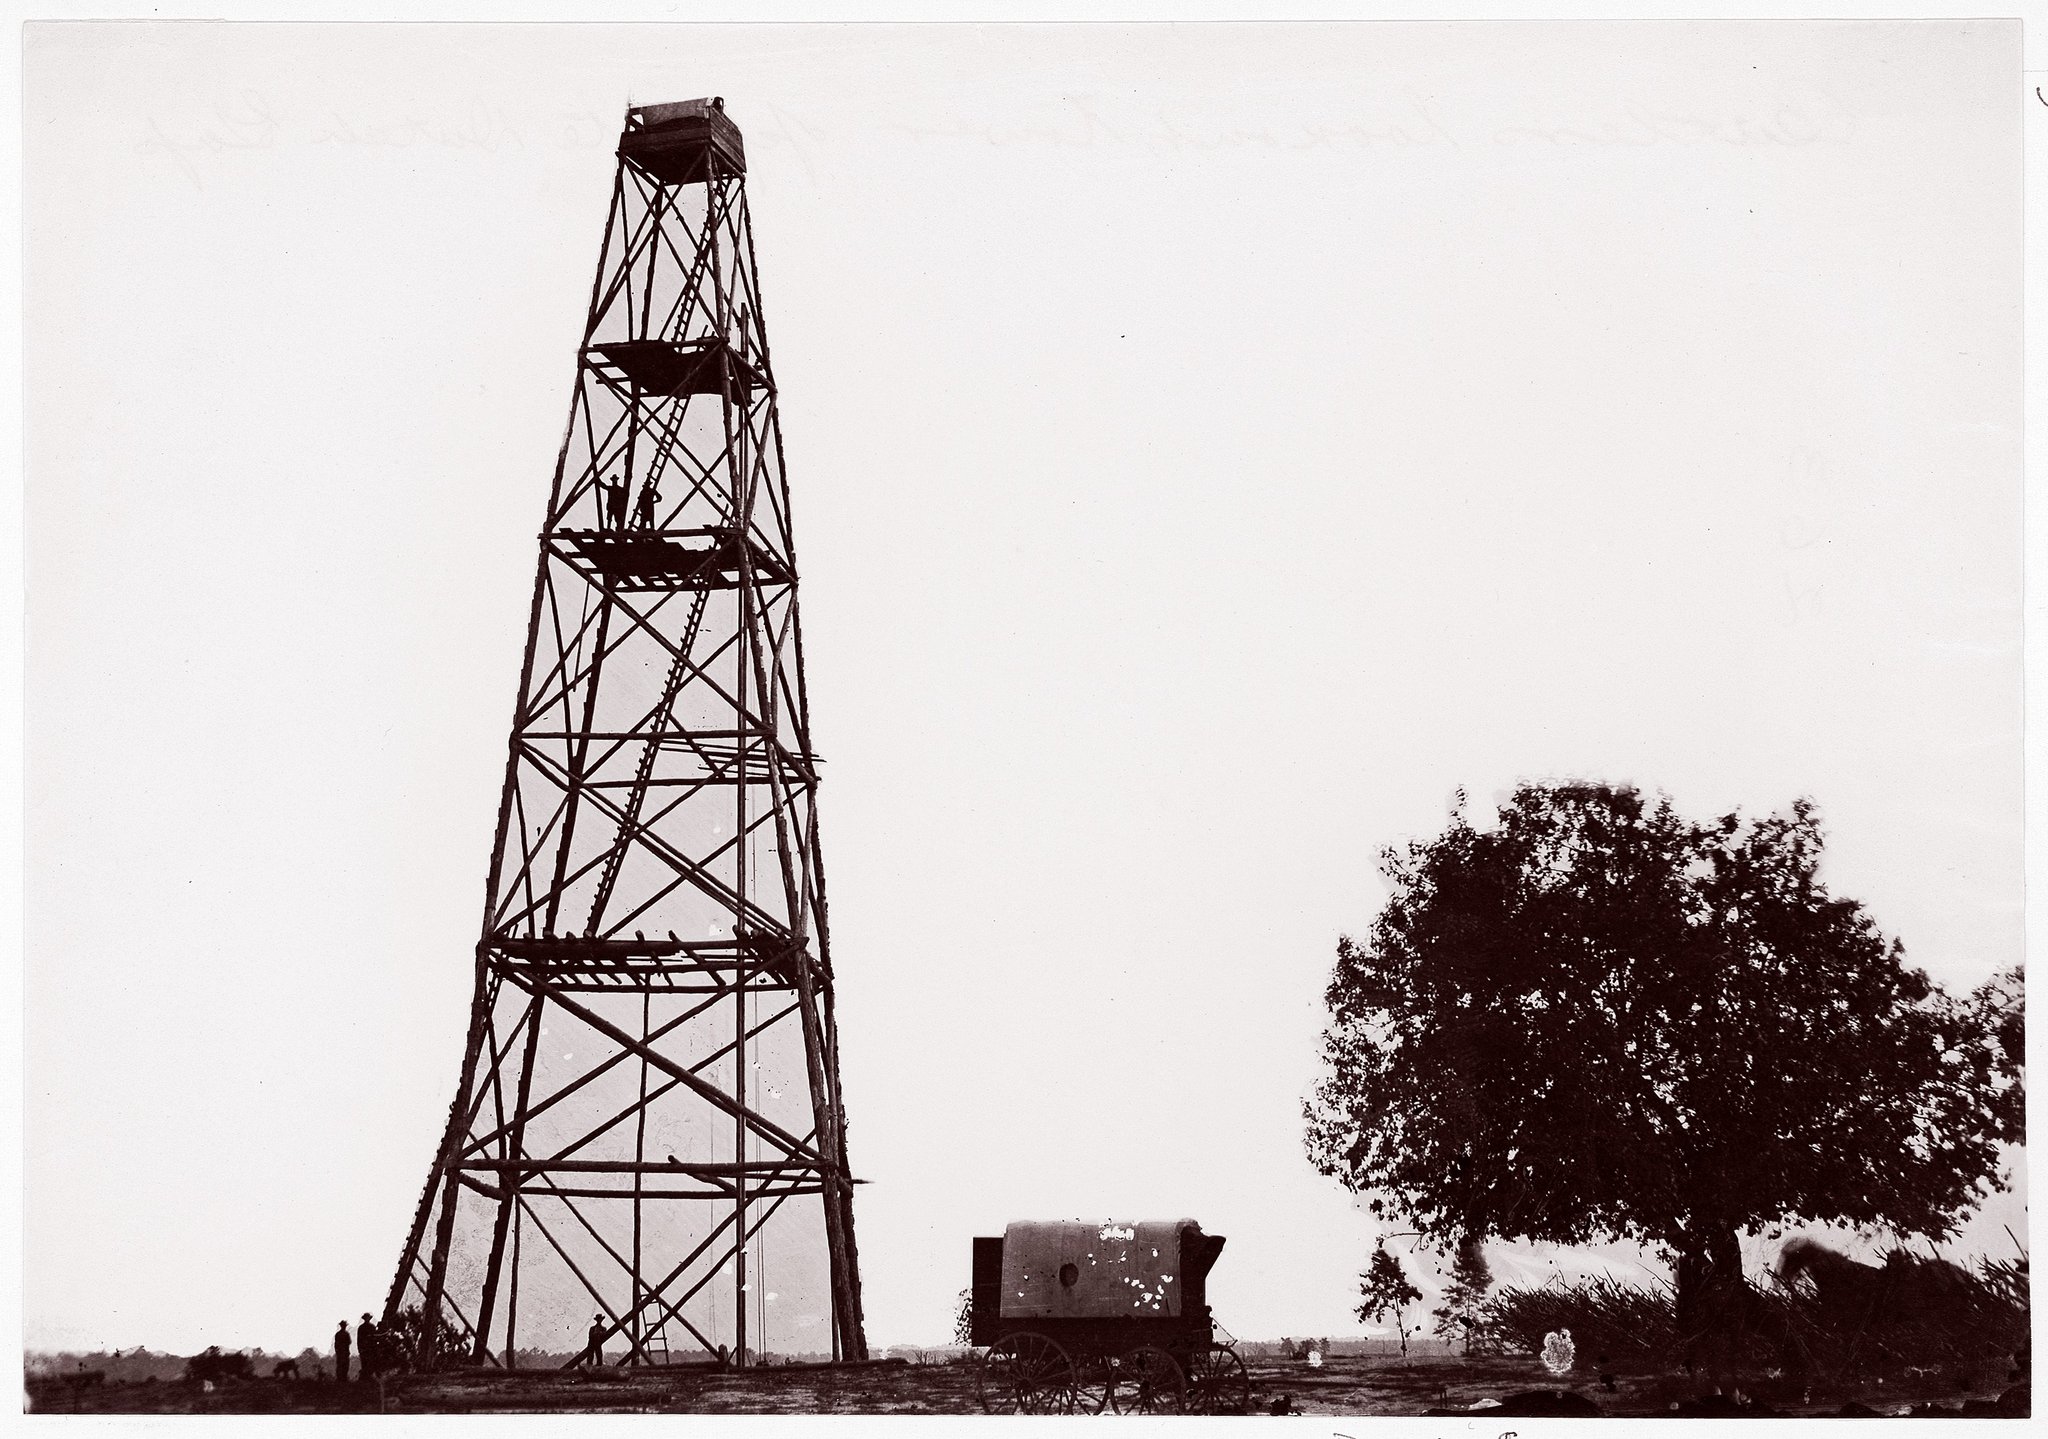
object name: photograph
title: Butler's Lookout Tower, Opposite Dutch Gap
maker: andrew joseph russell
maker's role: artist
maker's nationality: american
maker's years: 1830-1902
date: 1865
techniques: albumen silver print, glass negative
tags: towers,american civil war,wagons